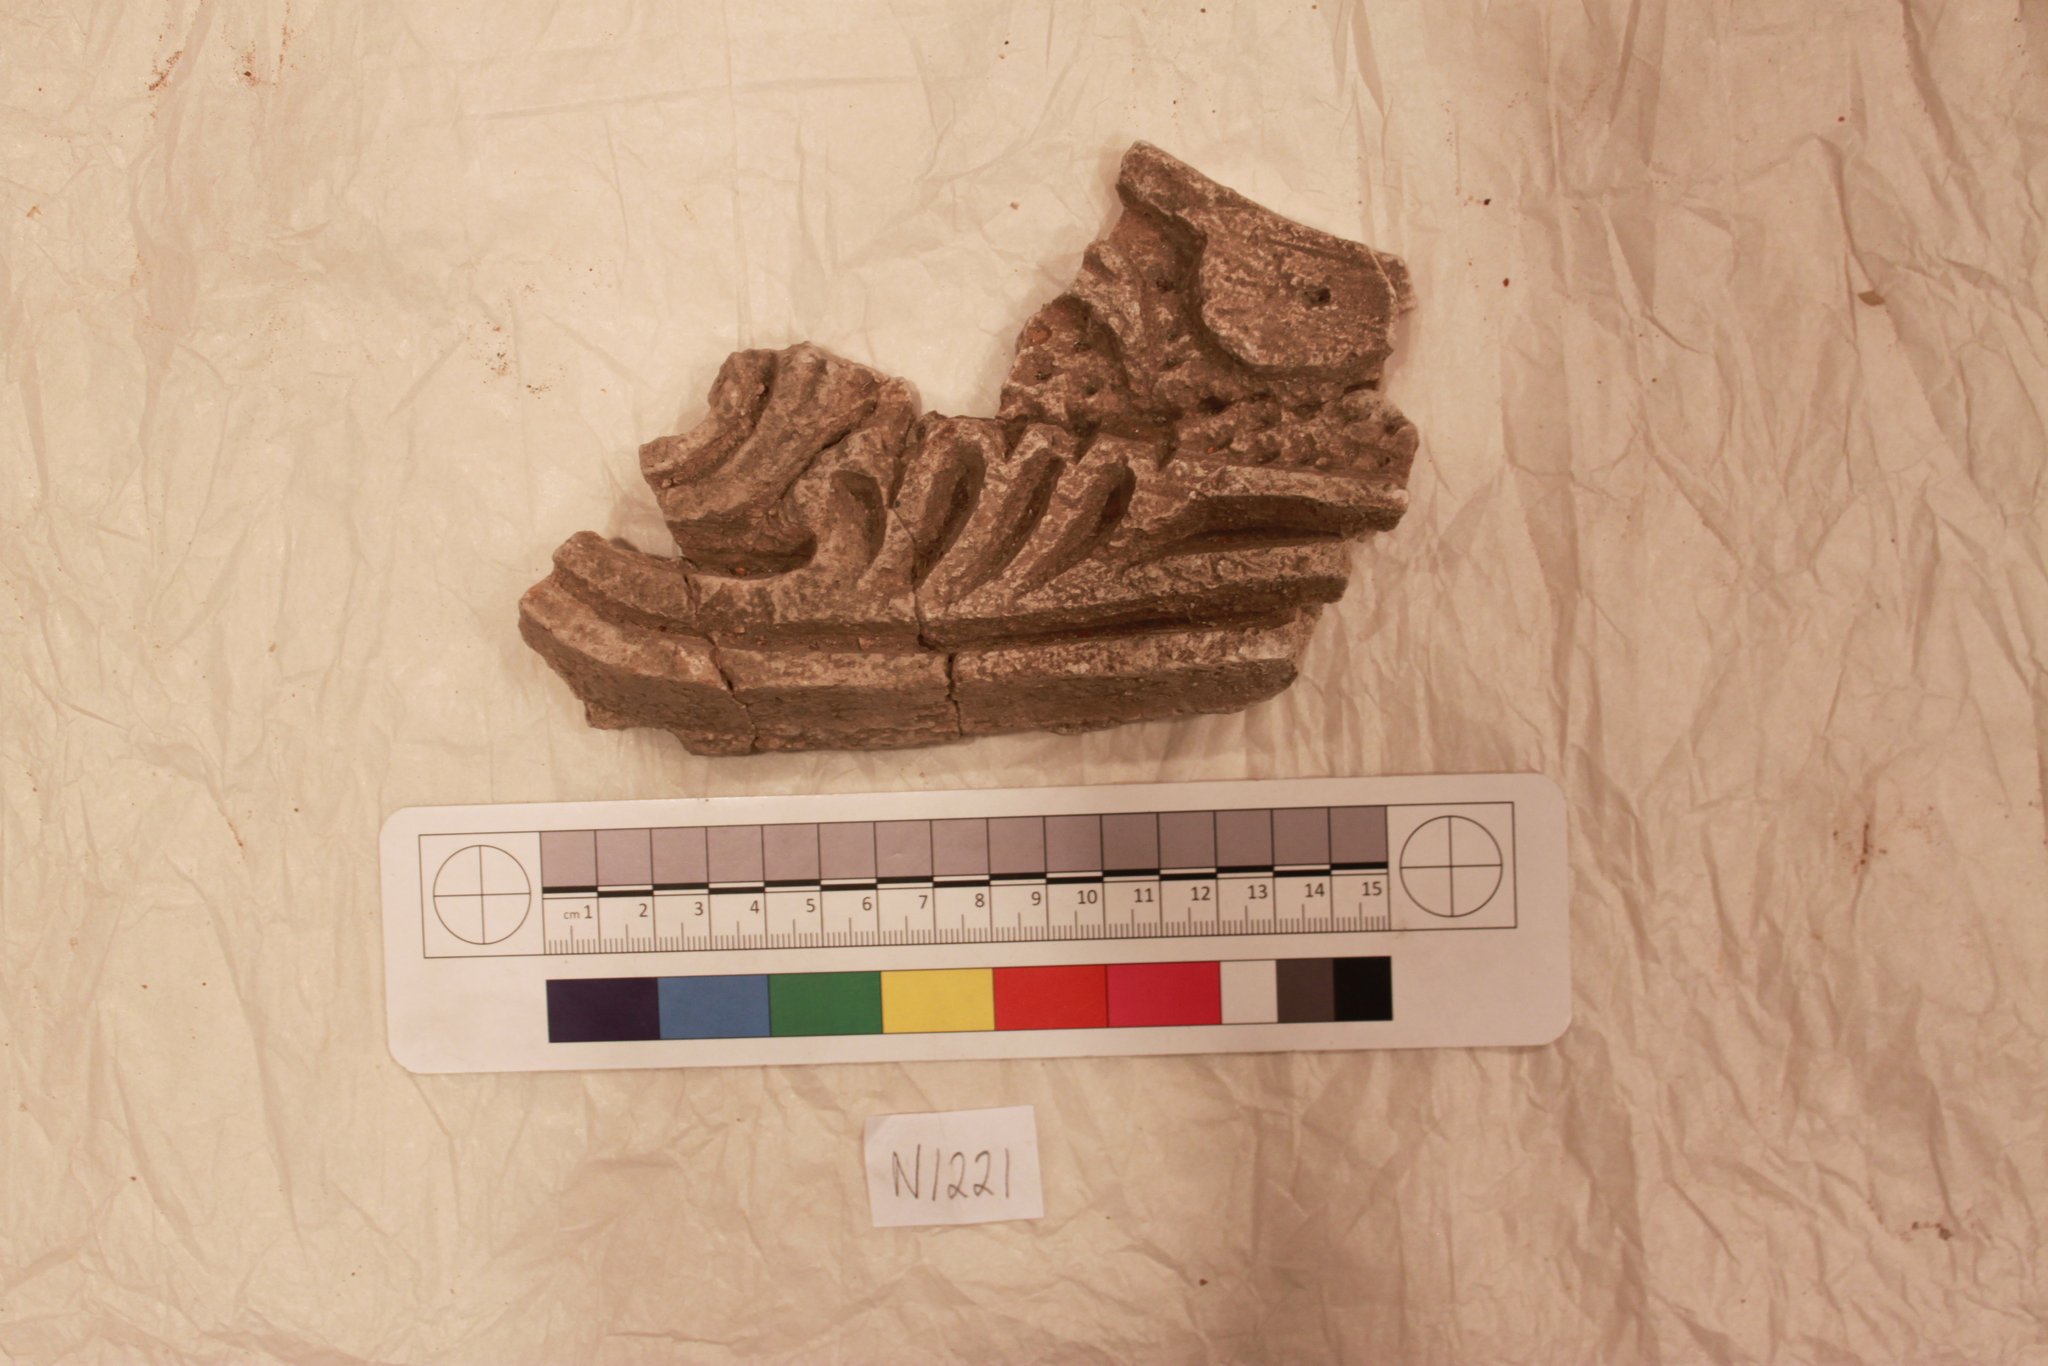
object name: fragment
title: Stucco Fragment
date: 701-1200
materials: plaster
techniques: carving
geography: iran